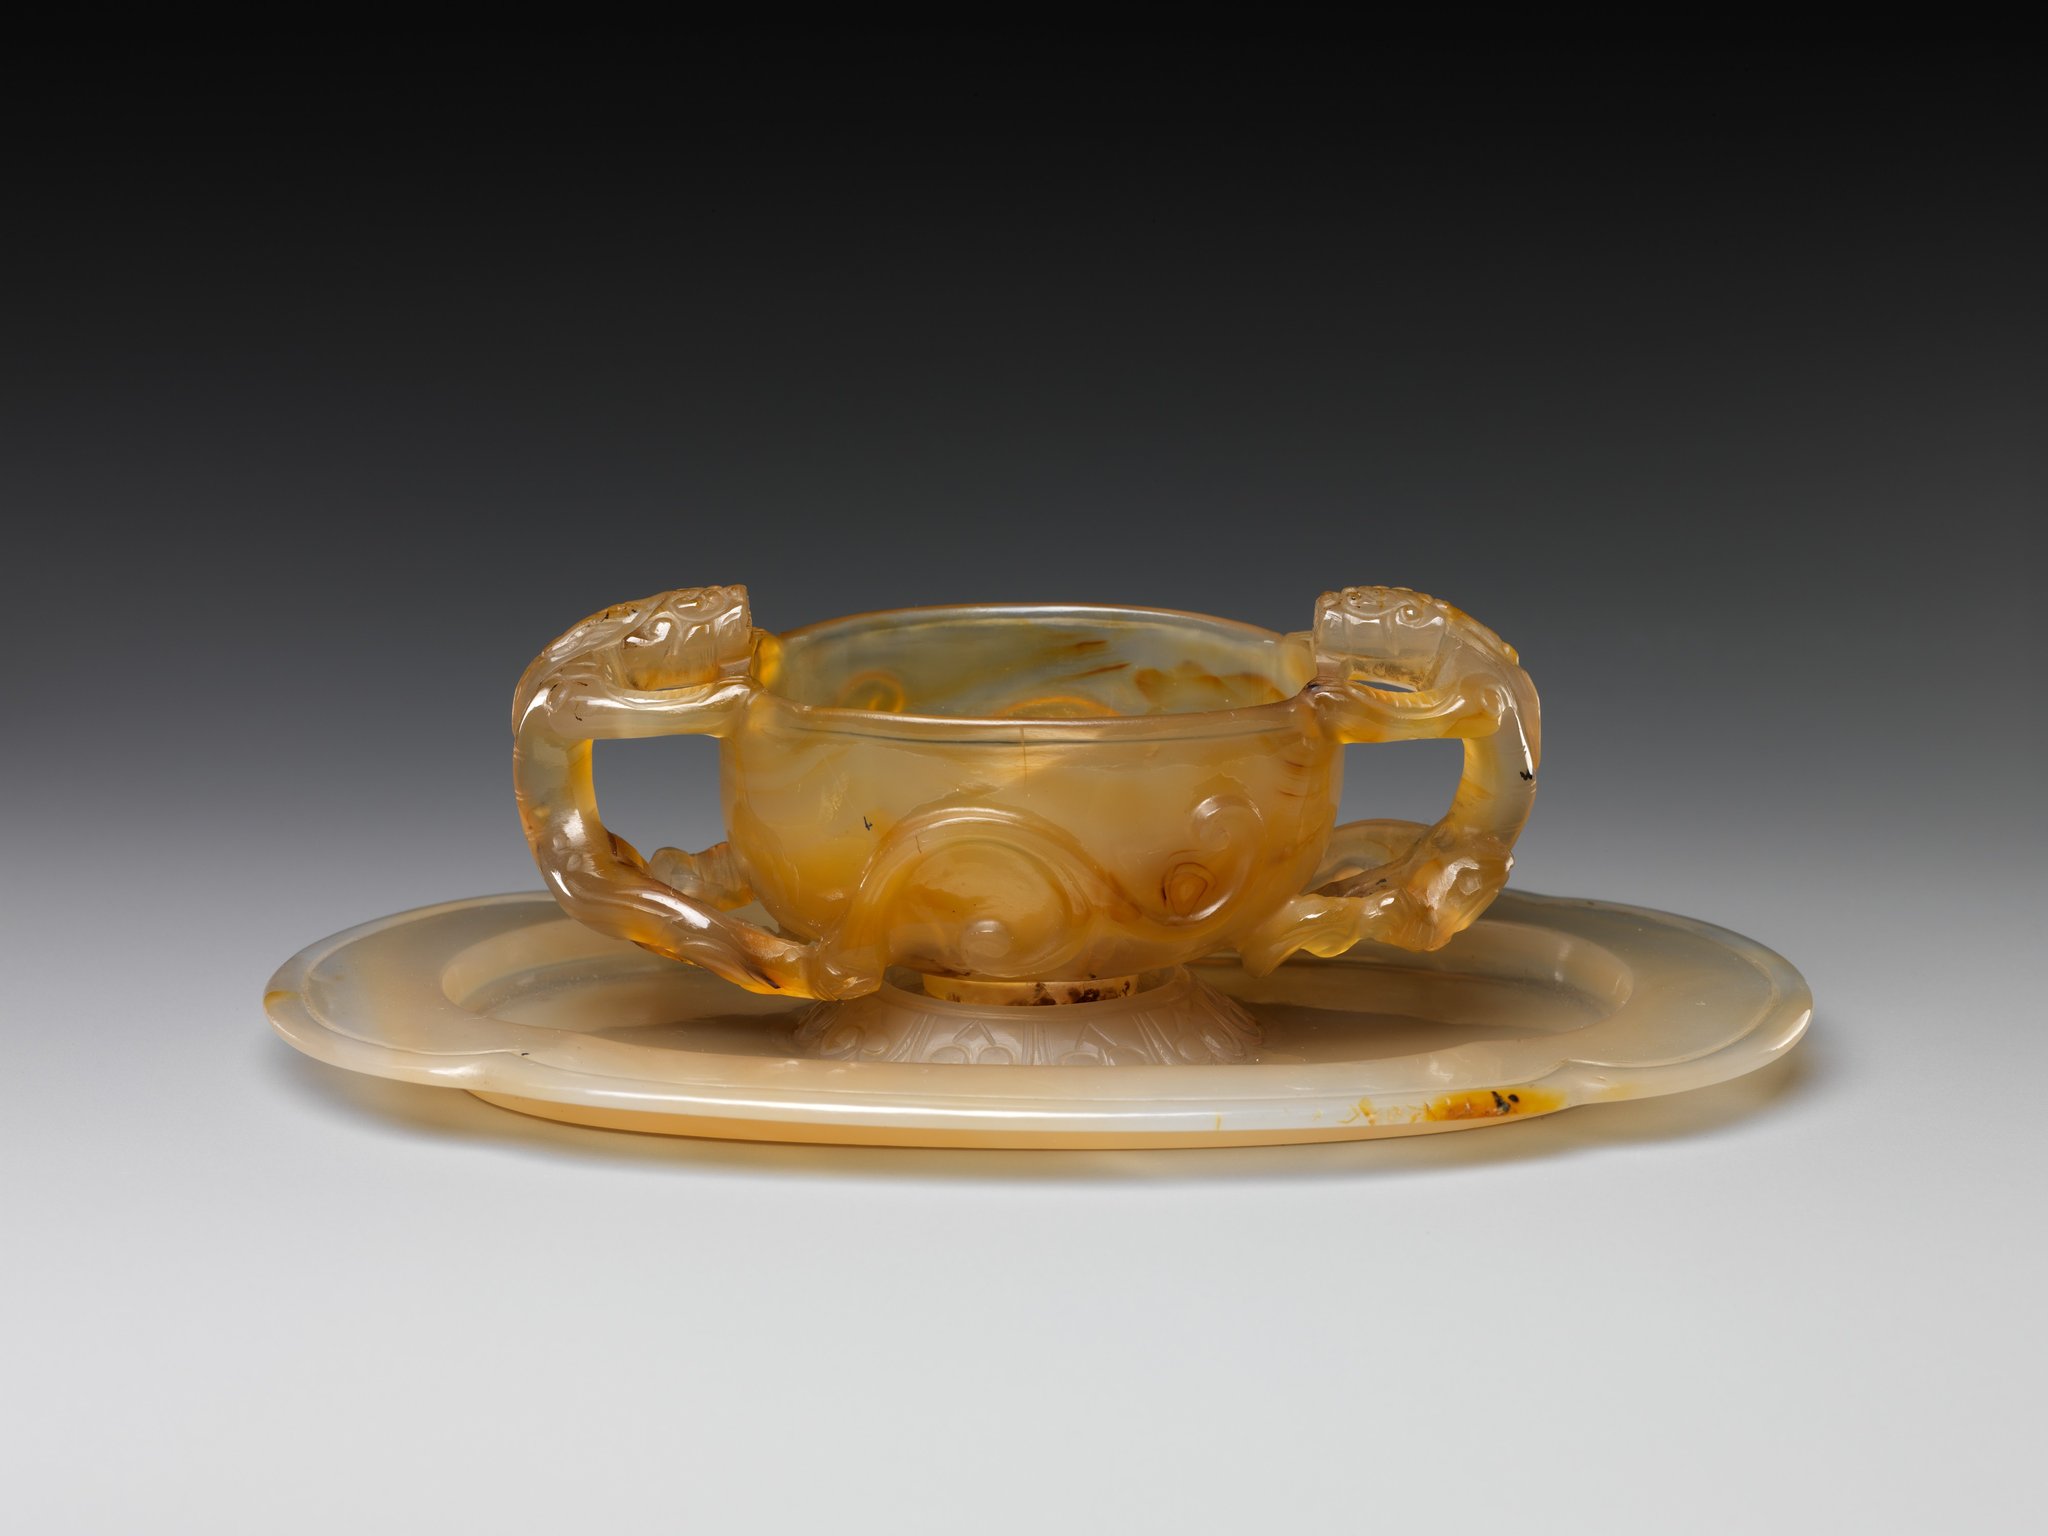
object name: cup and saucer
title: Cup with dragon handles and saucer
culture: chinese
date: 1701-1800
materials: stone